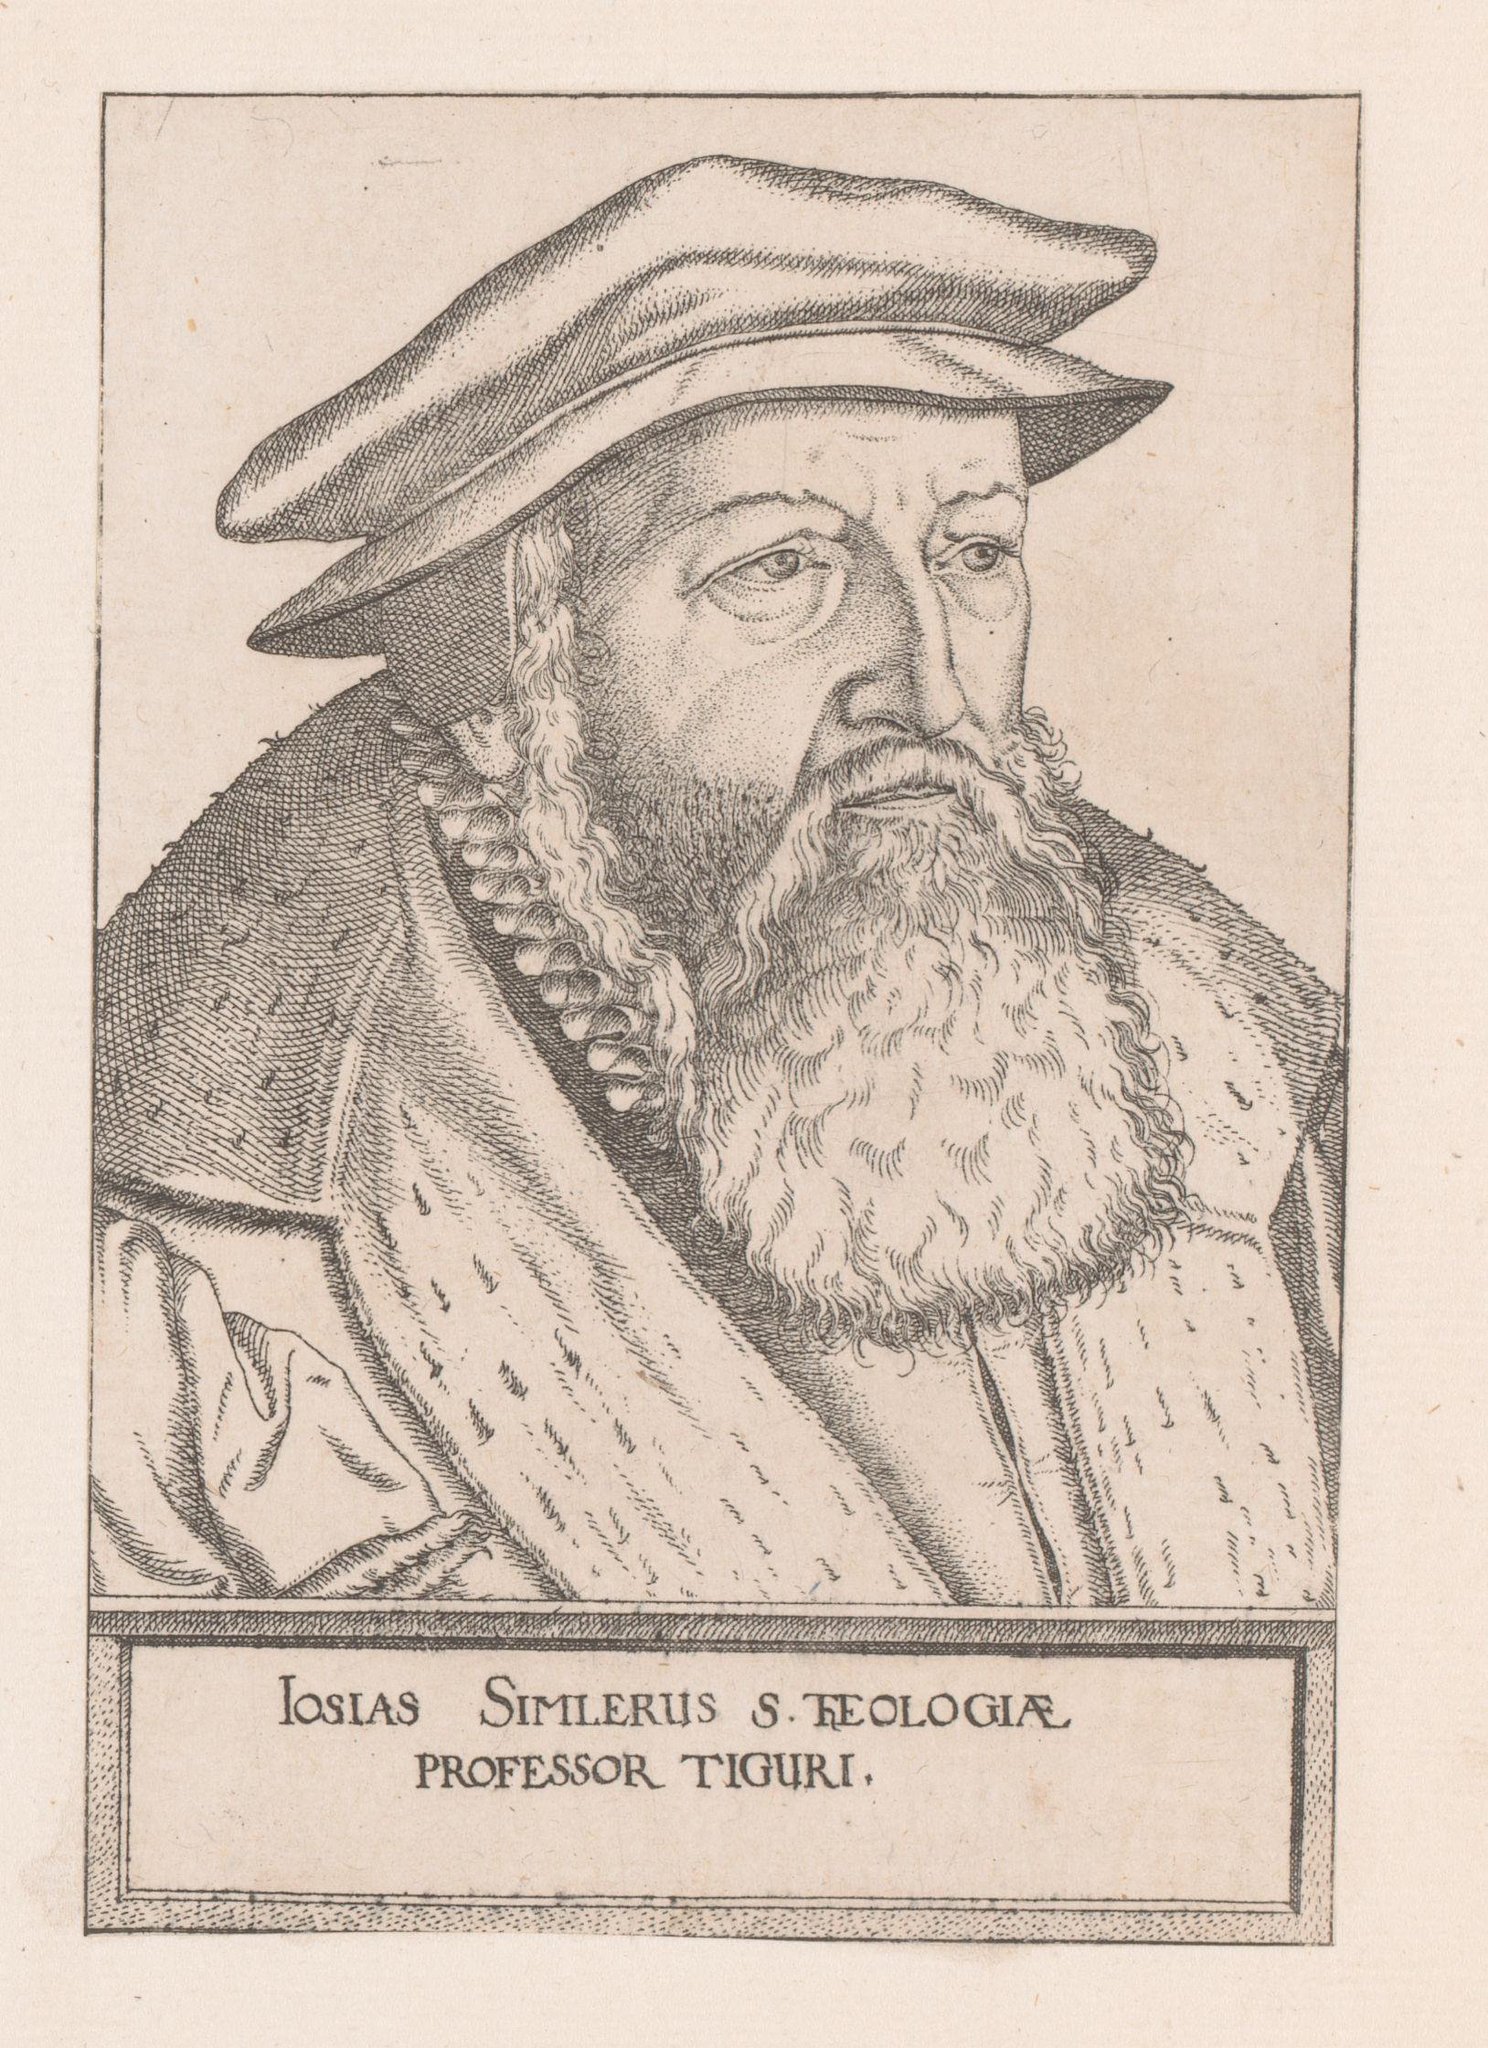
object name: print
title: Portret van Josias Simler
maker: dietrich meyer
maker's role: painter, print maker, publisher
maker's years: 1572-1658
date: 1582-1658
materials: paper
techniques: etching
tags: theologian, historical persons